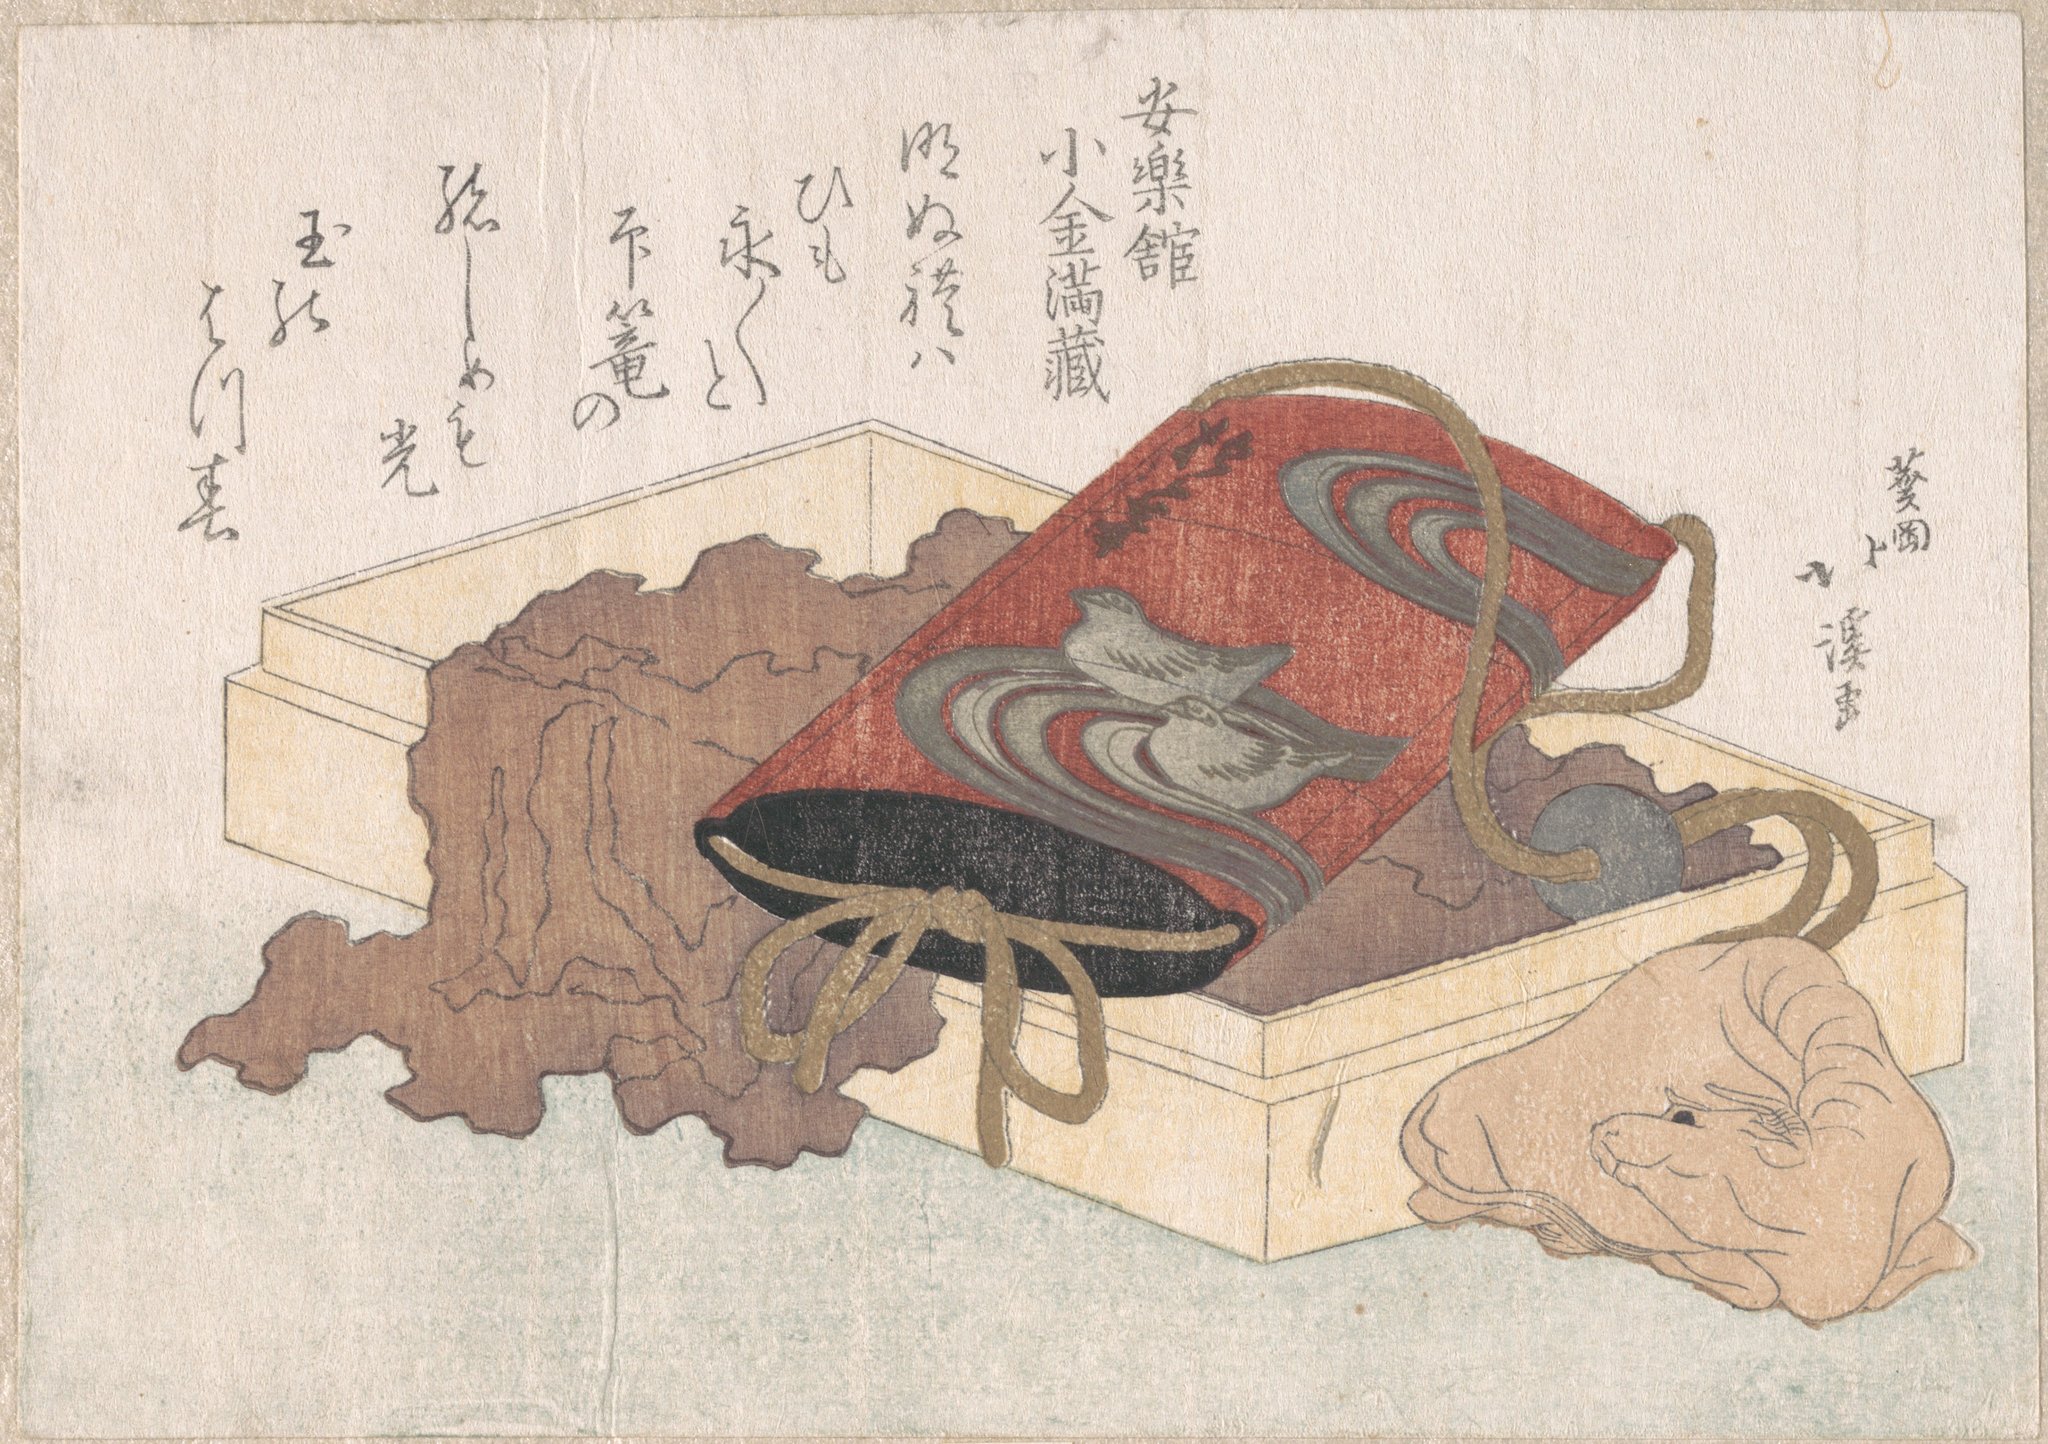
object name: woodblock print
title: Lacquer Inrō with Waterbirds and Ox-shaped Netsuke in a Box From the Spring Rain Collection (Harusame shū), vol. 3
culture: japanese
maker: totoya hokkei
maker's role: artist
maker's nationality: japanese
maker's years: 1780-1850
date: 1817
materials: ink, paper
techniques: surimono, woodblock print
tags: birds,ox